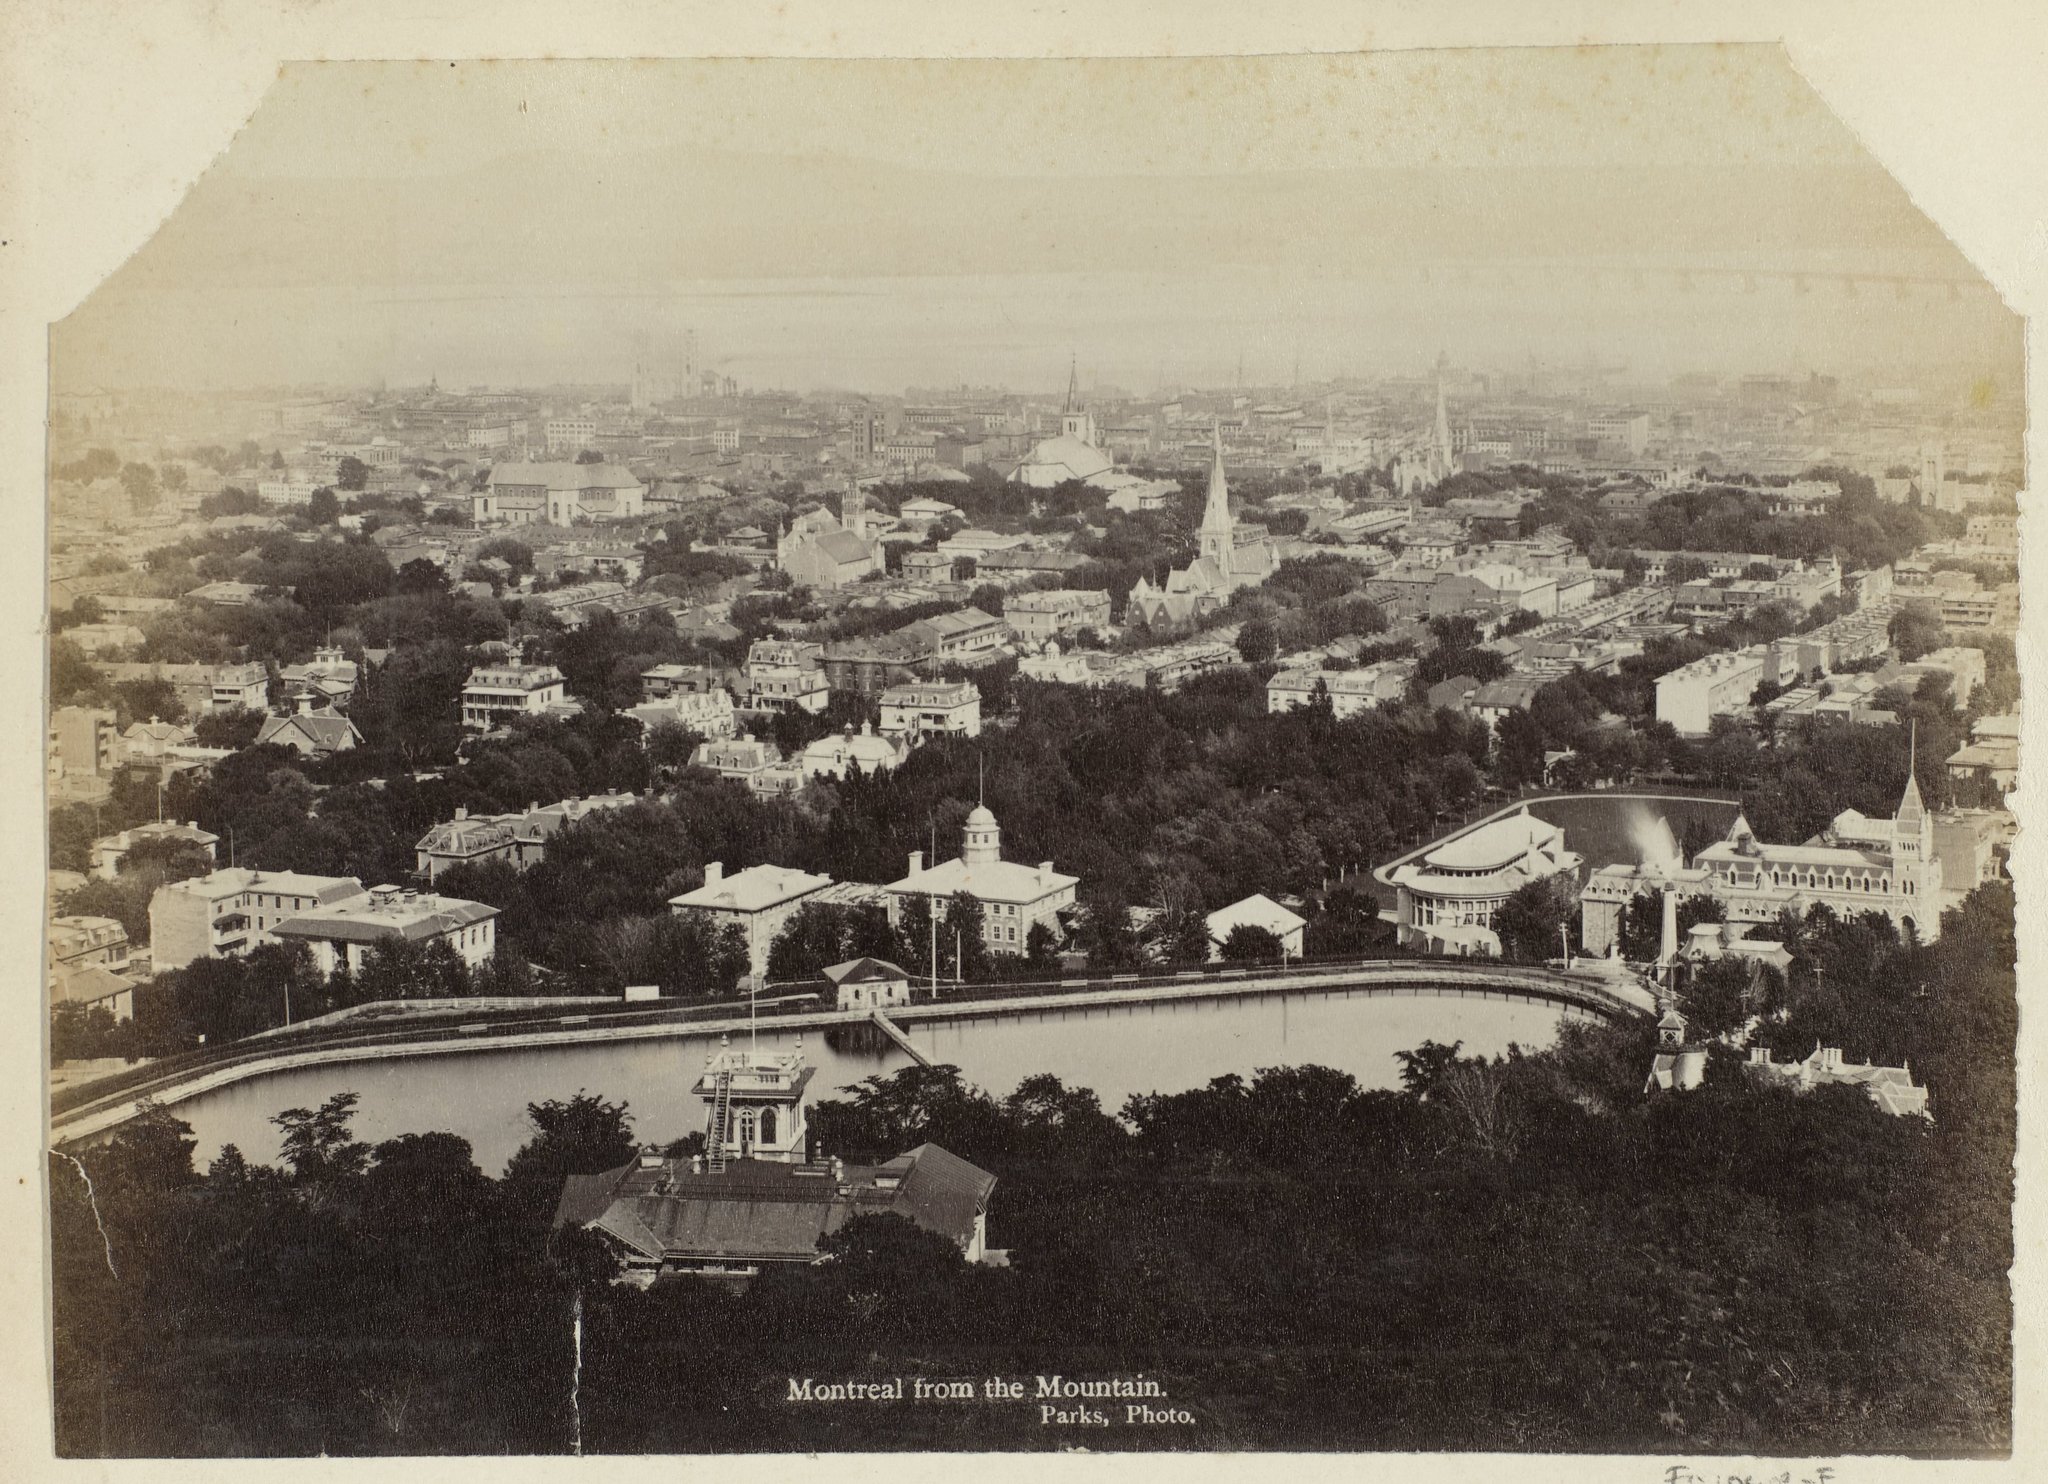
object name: photograph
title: Montréal (Canada) gezien vanaf de Koninklijke Berg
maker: j.g. parks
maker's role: fotograaf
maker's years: 1836-1895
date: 1870-1887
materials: paper, photographic support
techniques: albumen print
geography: montreal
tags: prospect of city, town panorama, silhouette of city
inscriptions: date: ‘1887’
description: Onderdeel van Reisalbum van H. Dunlop met foto's van bezienswaardigheden in Perzië, Schotland, Duitsland, Rusland, China en Canada.